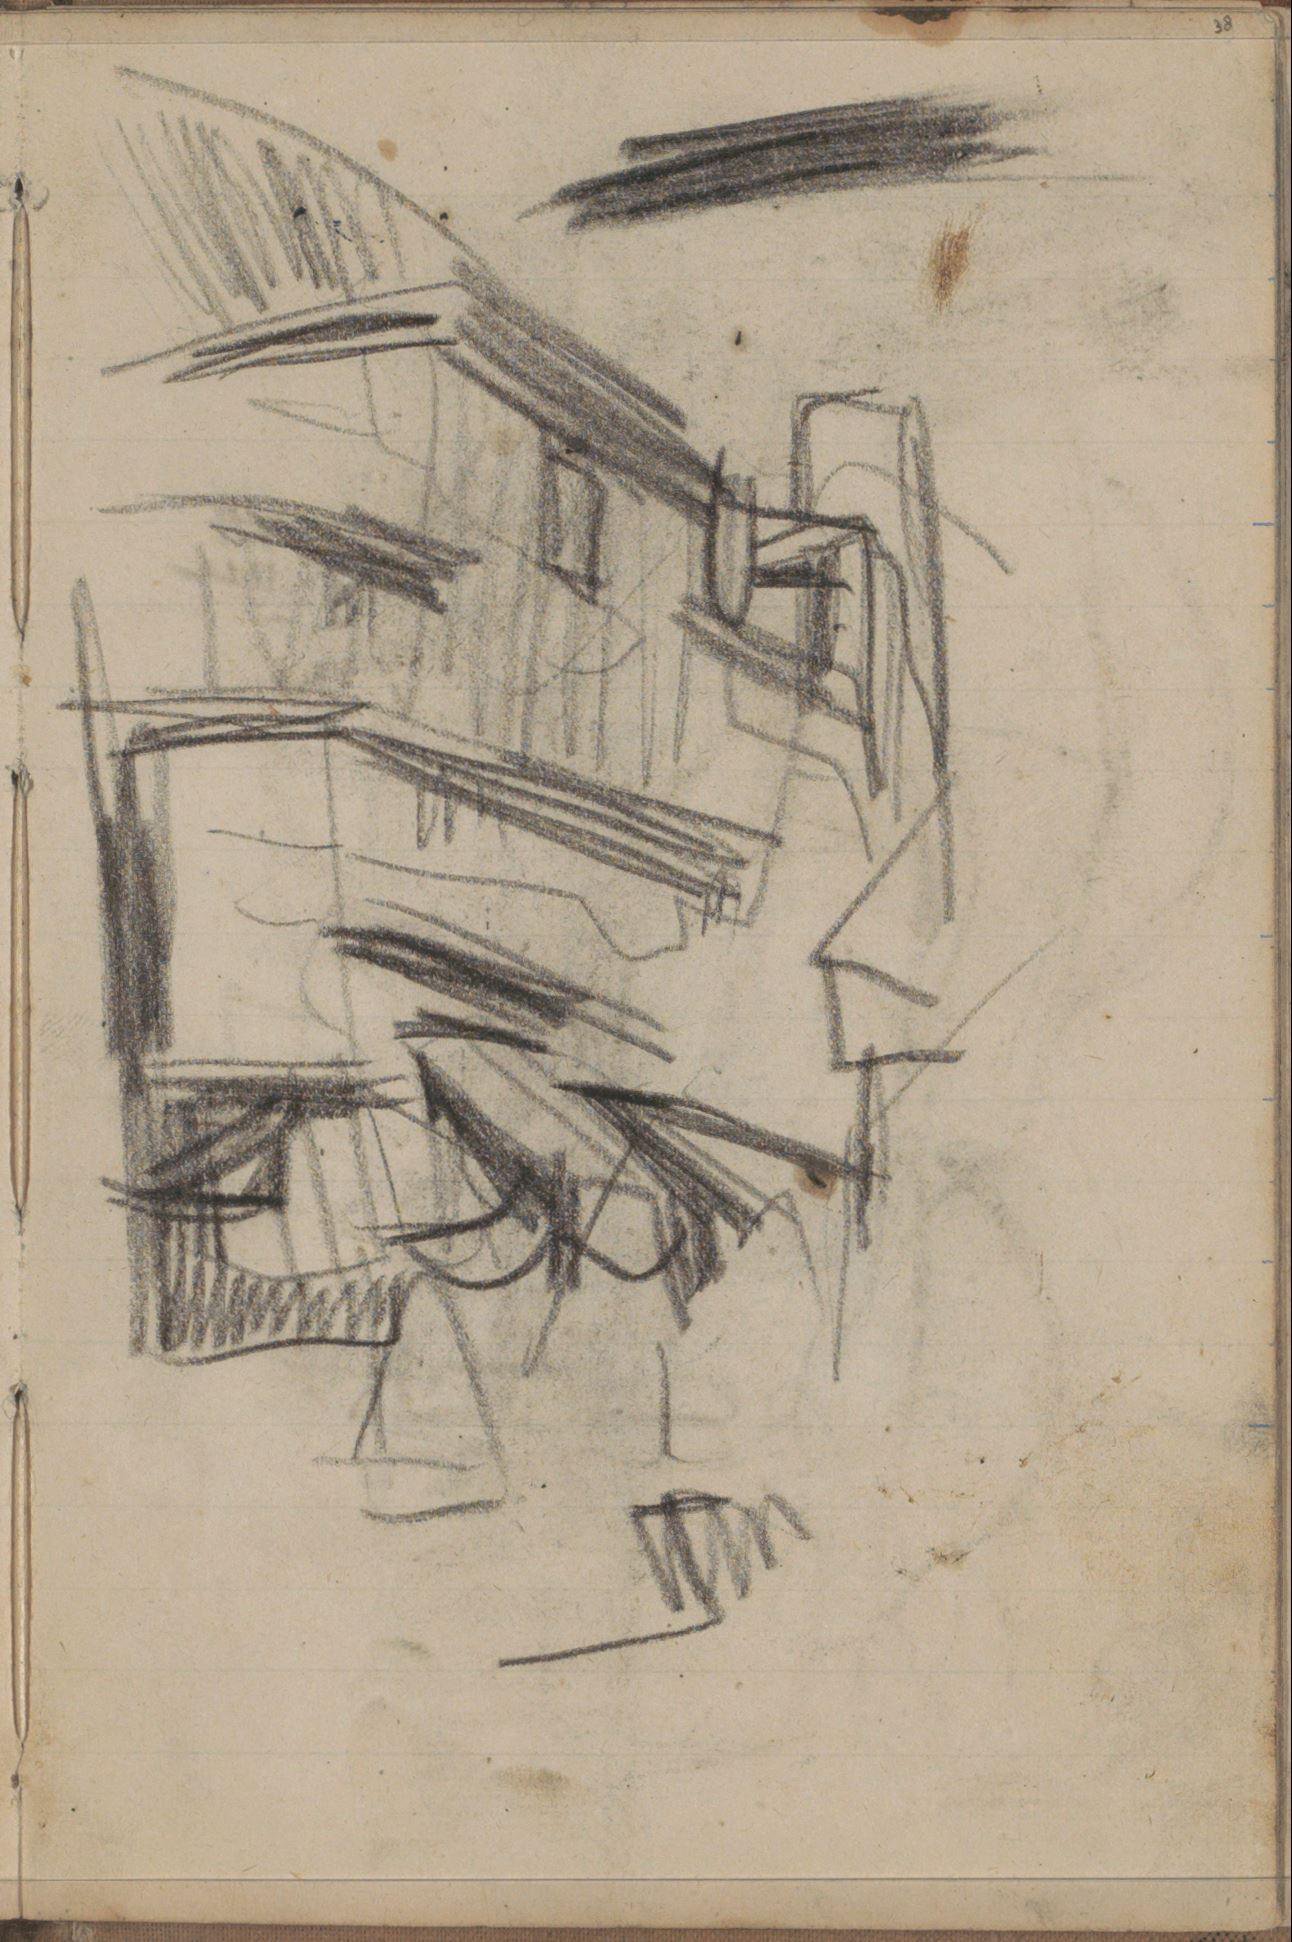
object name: sketchbook leaf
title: Architectuurstudie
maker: marius bauer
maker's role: draughtsman, print maker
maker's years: 1867-1932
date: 1888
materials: chalk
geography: istanbul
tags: architecture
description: Pagina 38 uit een schetsboek met 58 bladen.